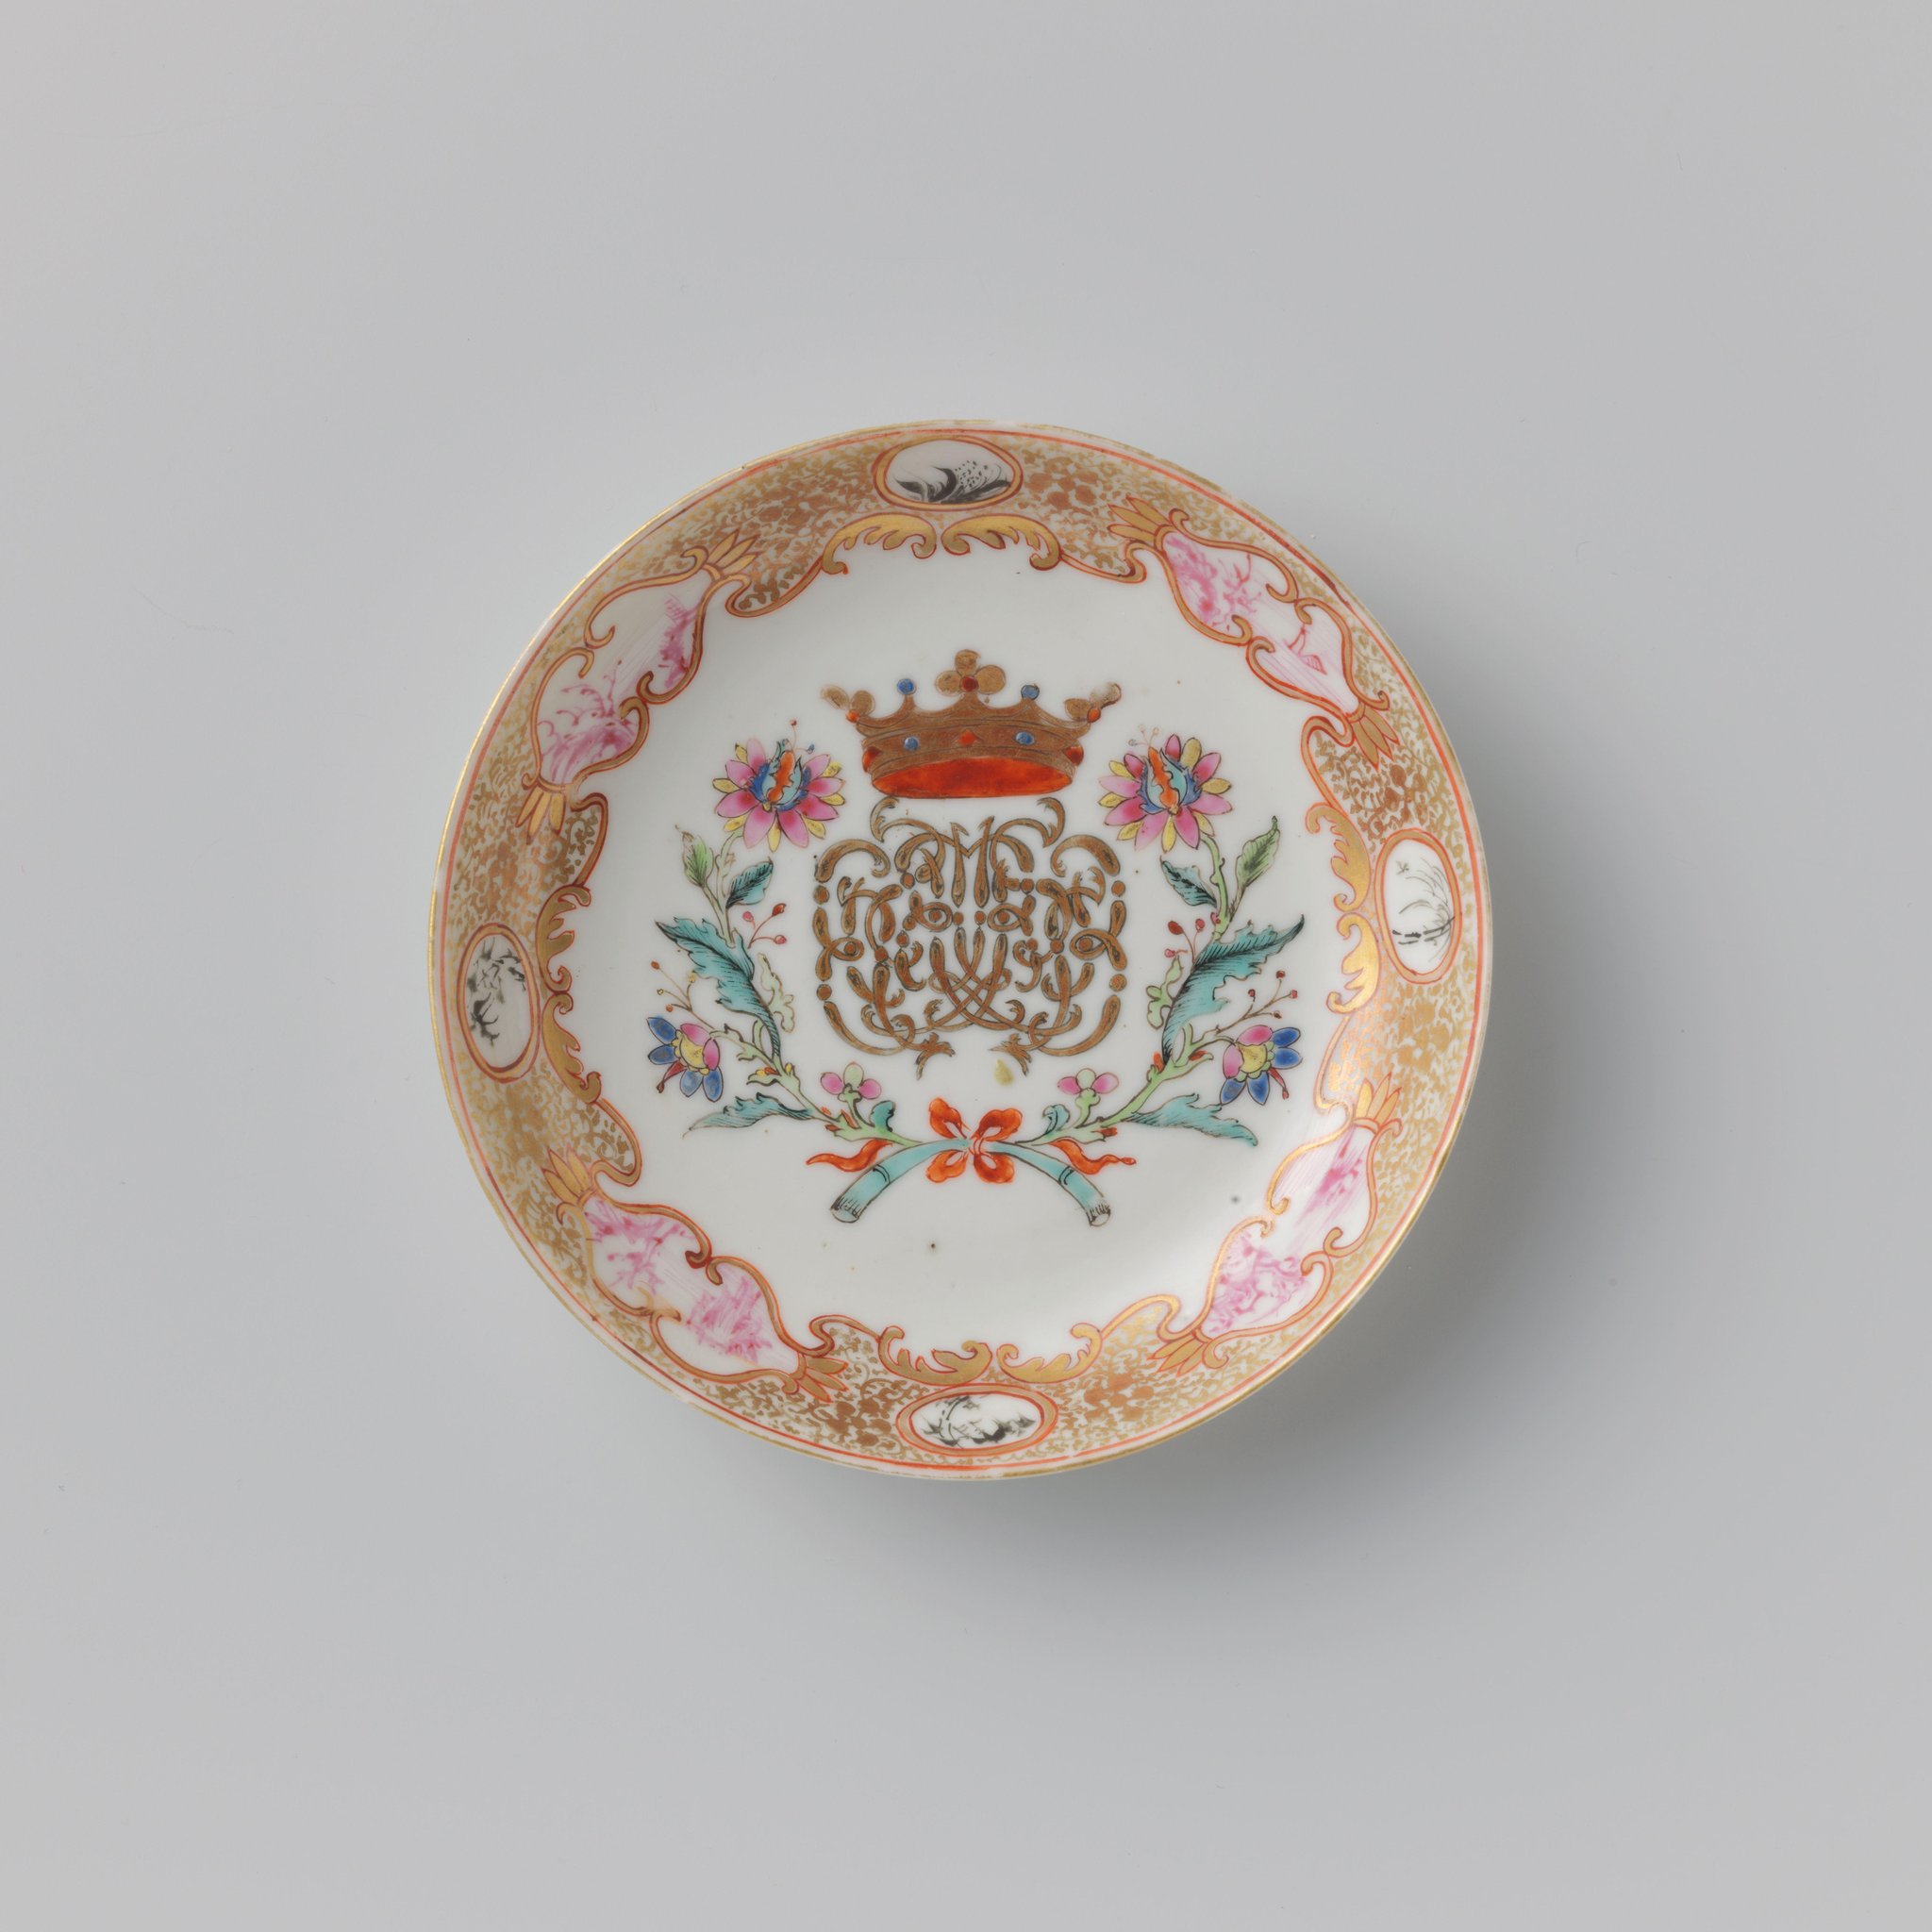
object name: platter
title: Saucer with a crowned, illegible monogram surrounded by two flower sprays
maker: Anonymous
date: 1750-1774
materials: glaze, gold, paint, porcelain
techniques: firing, gilding, turning, vitrification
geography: china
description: Schotel van porselein, beschilderd op het glazuur in blauw, rood, roze, groen, geel, zwart en goud. Op het plat een gekroond, onleesbaar monogram omringd door twee bloemtakken; de wand met bloemranken met daarin uitgespaard vier cartouches met een landschap en vier medaillons met planten. Europese voorstelling in emailkleuren.